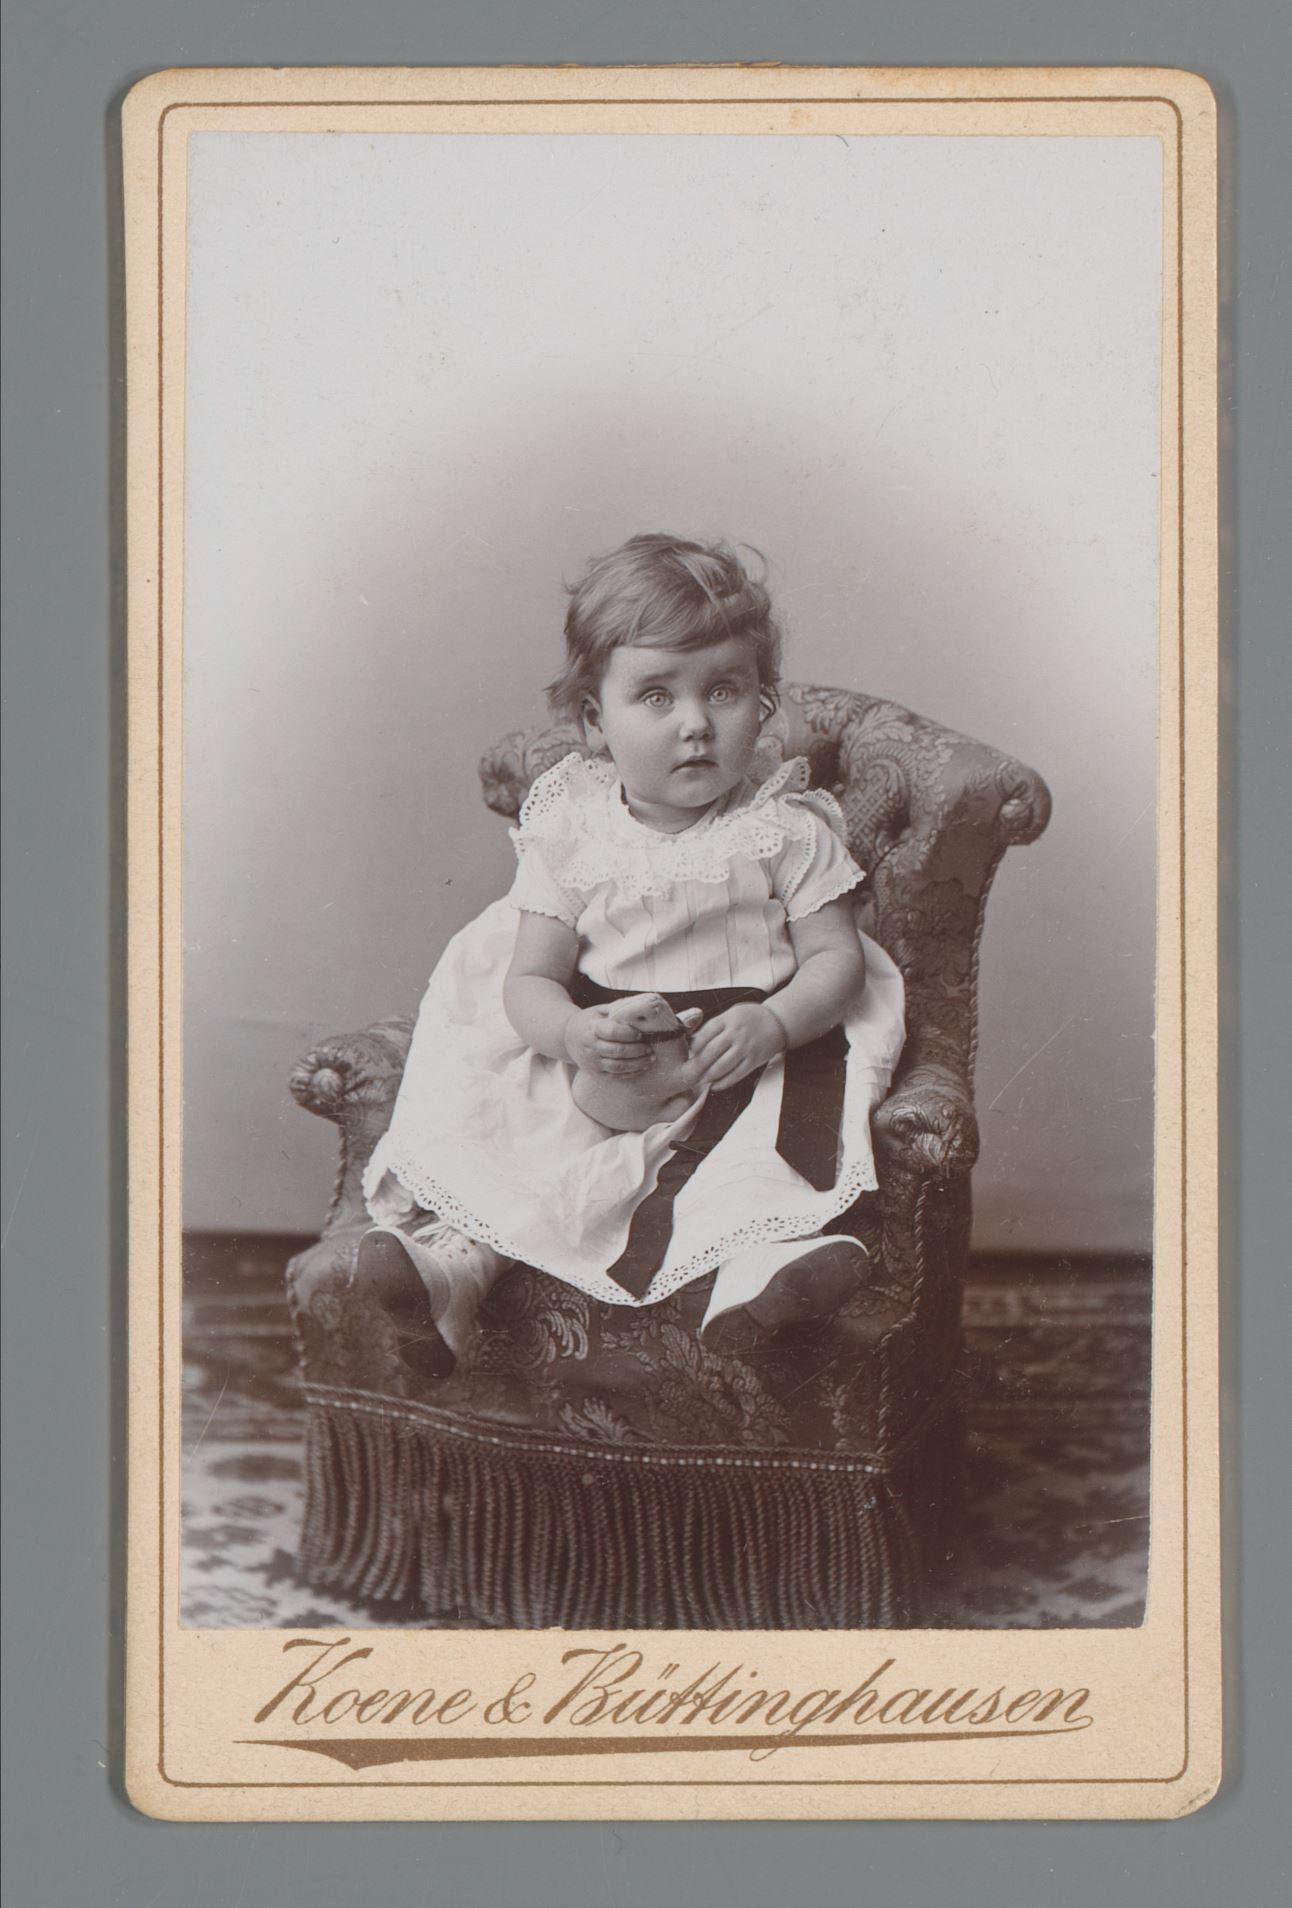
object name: photograph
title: Portret van Willem Jonker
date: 1899-1900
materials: cardboard, photographic support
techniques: collodion silver print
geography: amsterdam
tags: historical persons, amsterdam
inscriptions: workshop stamp: ‘Koene&Büttinghausen/ Amsterdam, Heerengracht 150/ Batavia’, annotation: ‘Hansje’